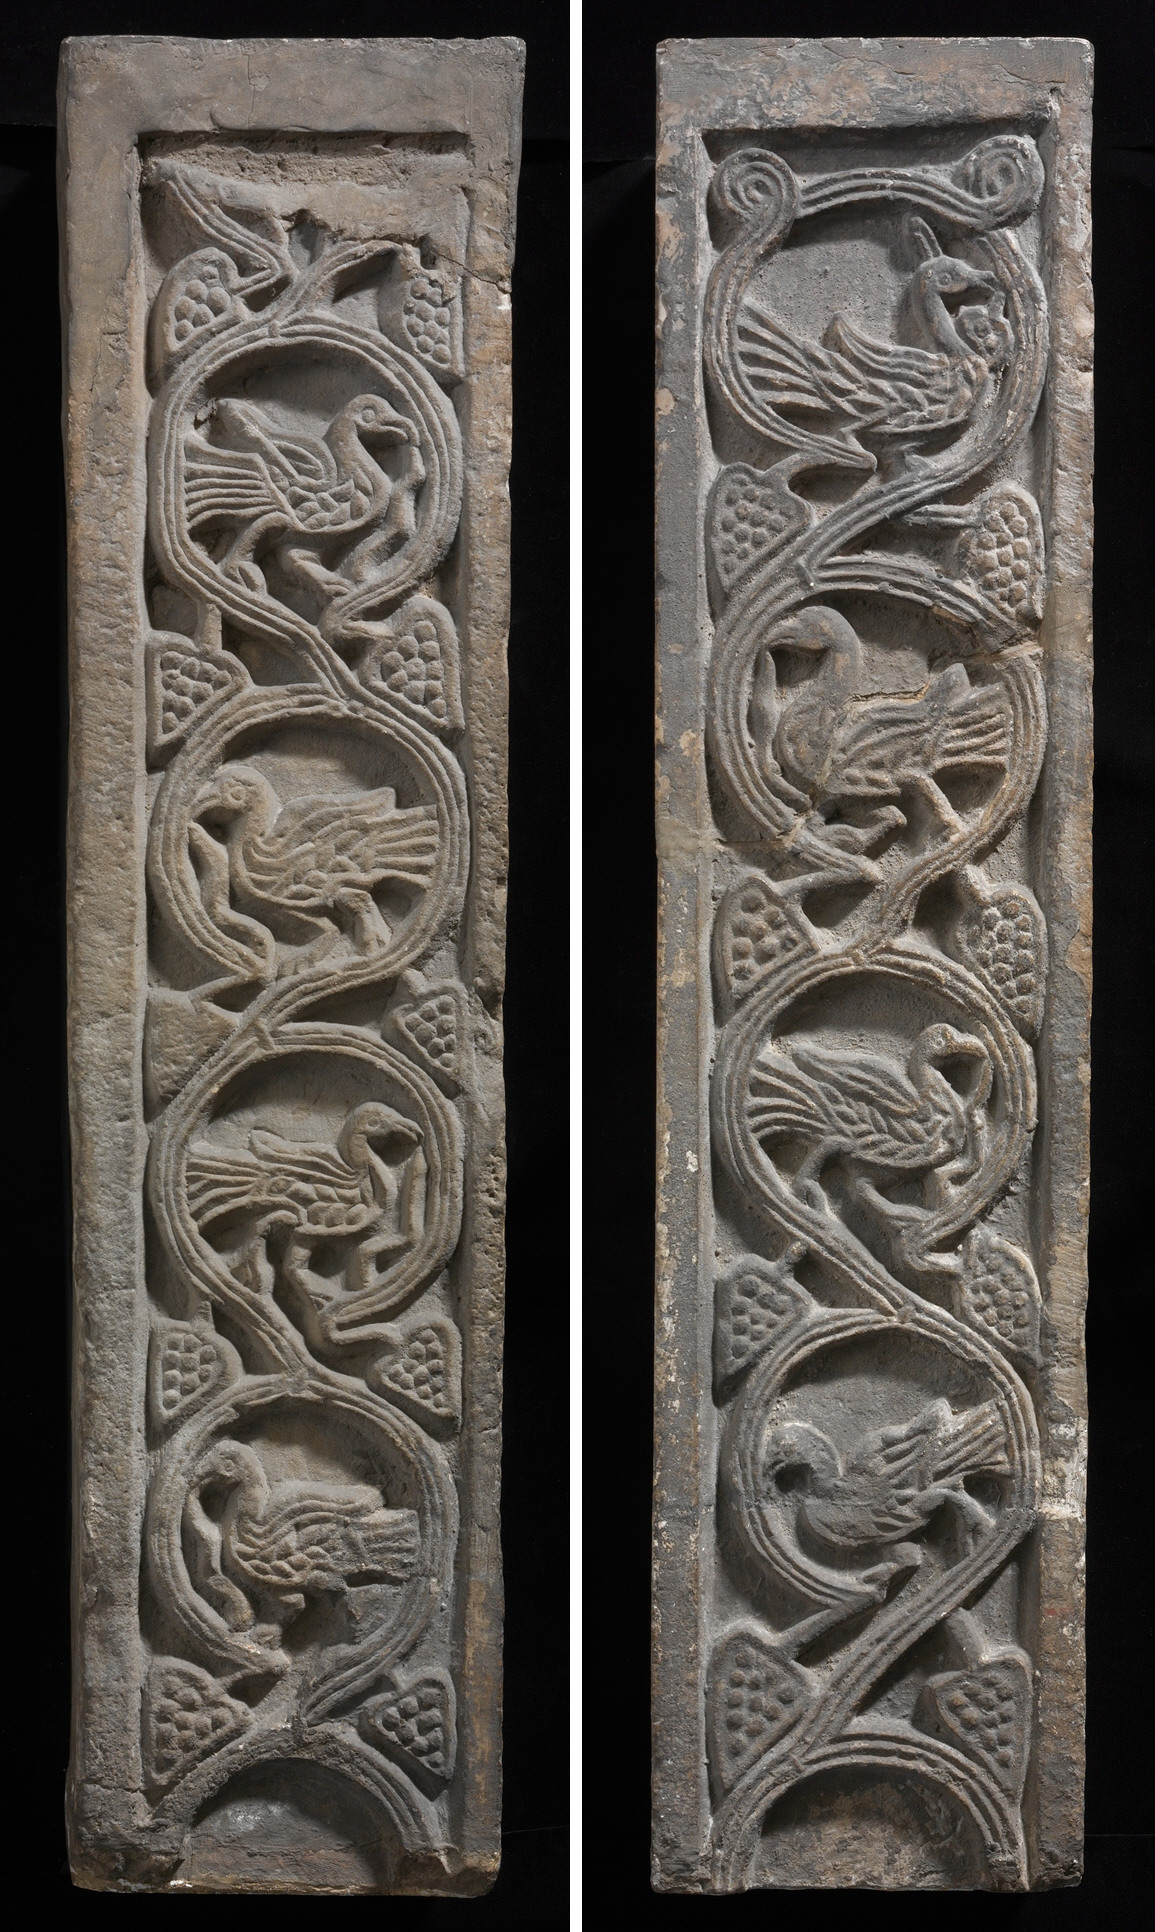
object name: pilaster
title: Pilasters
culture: north italian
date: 901-1100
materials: marble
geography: italy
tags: birds